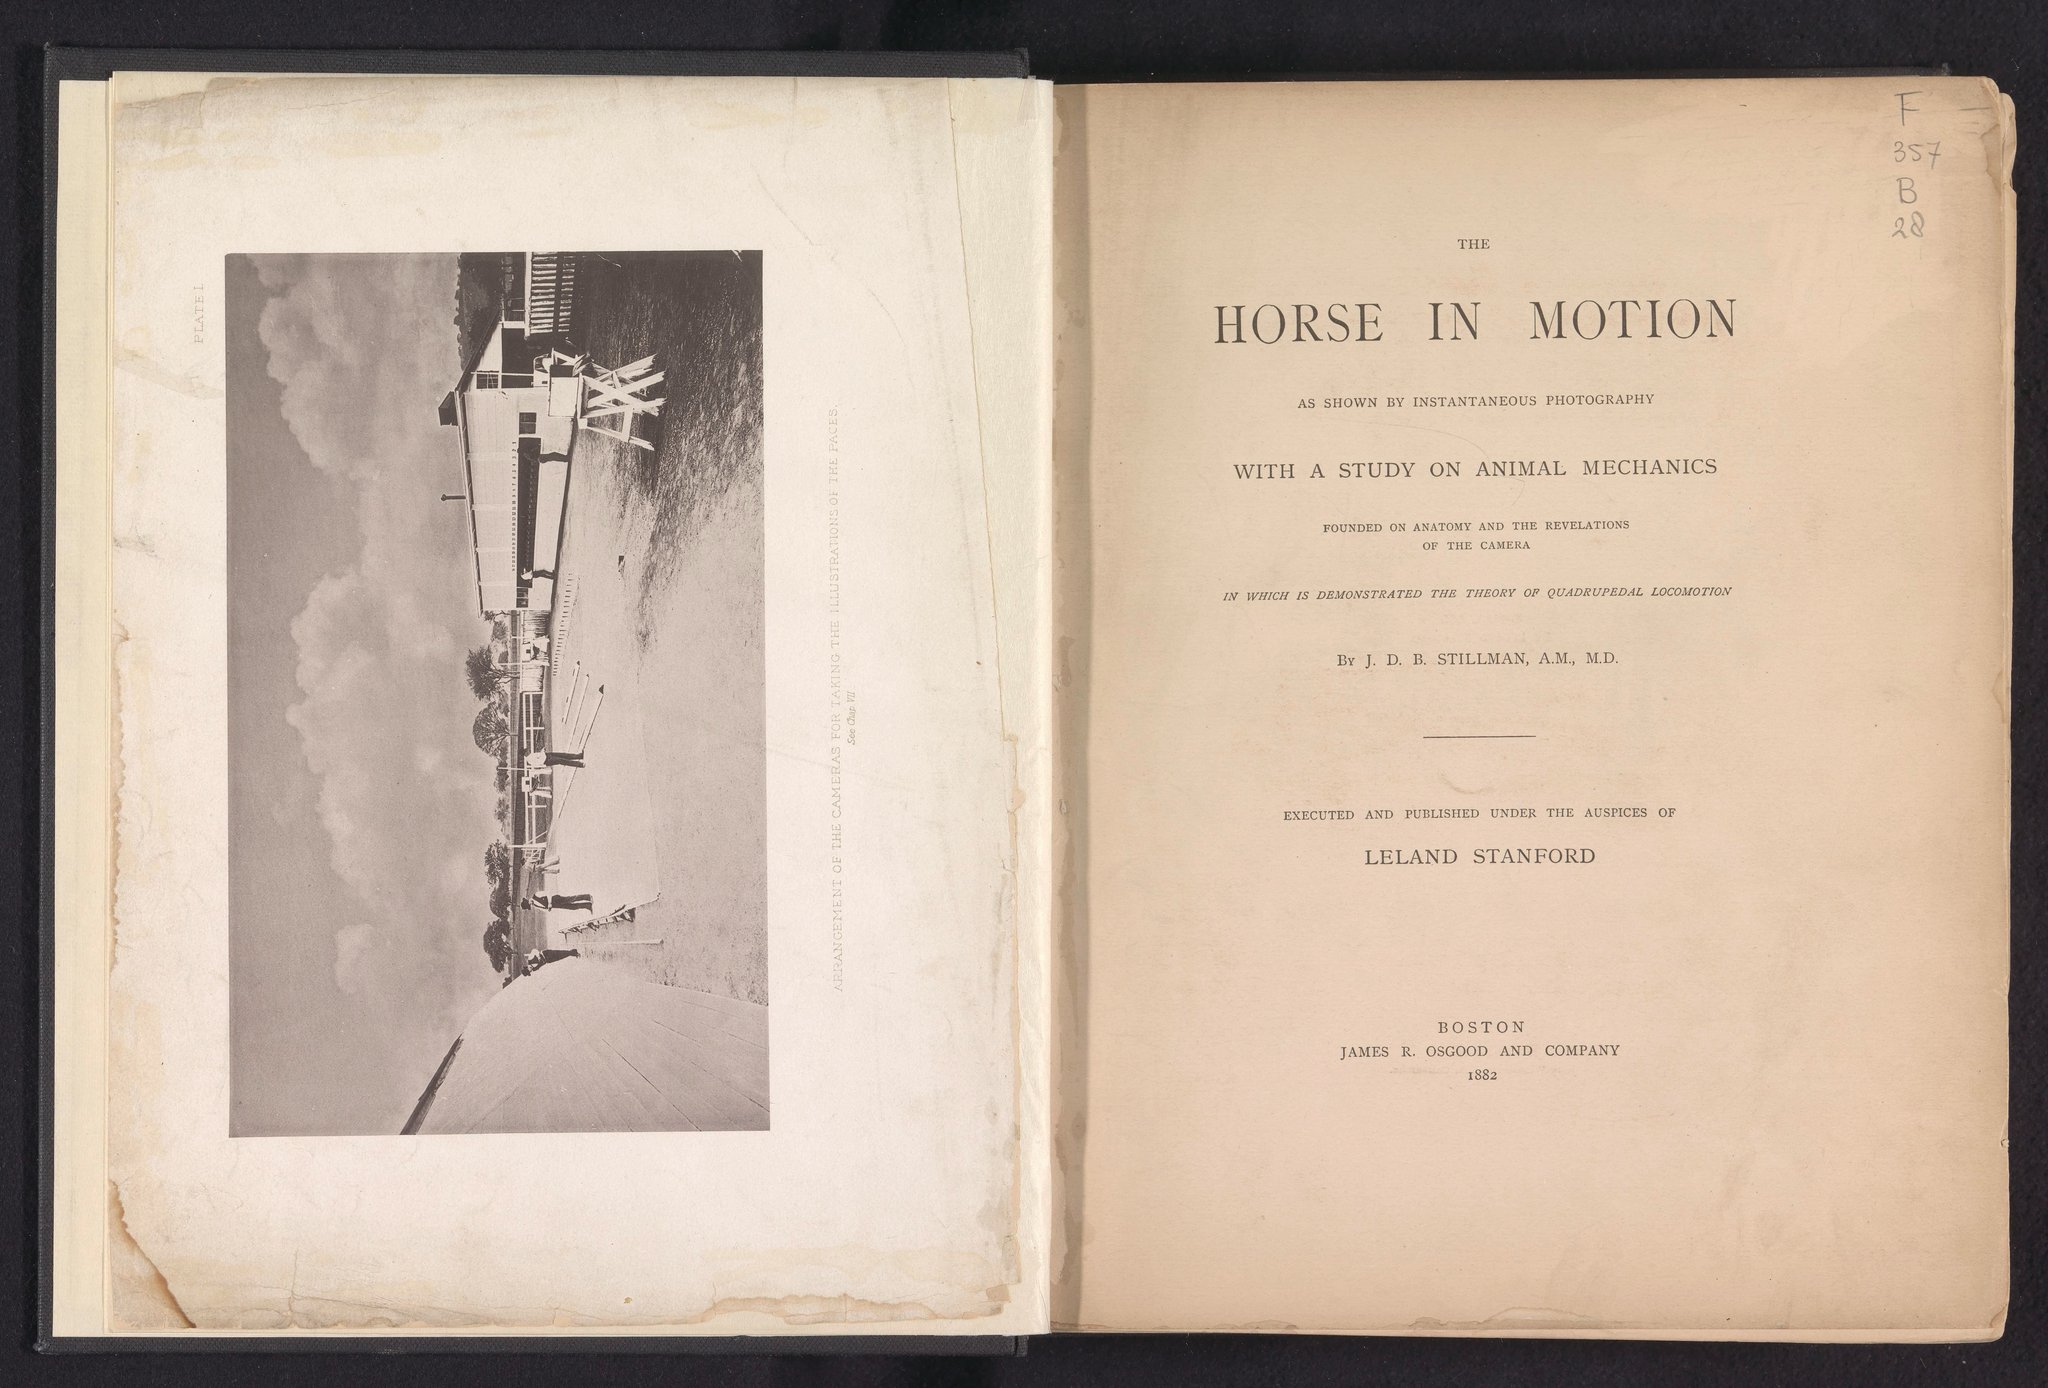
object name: page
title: Arrangement of the cameras for taking the illustrations of the paces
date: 1878-1882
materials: paper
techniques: photoaquatint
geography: stanford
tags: taking photographs - cc - out of doors, photographic apparatus, race-track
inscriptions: number: ‘Plate I.’, inscription: ‘See Chap. VII’